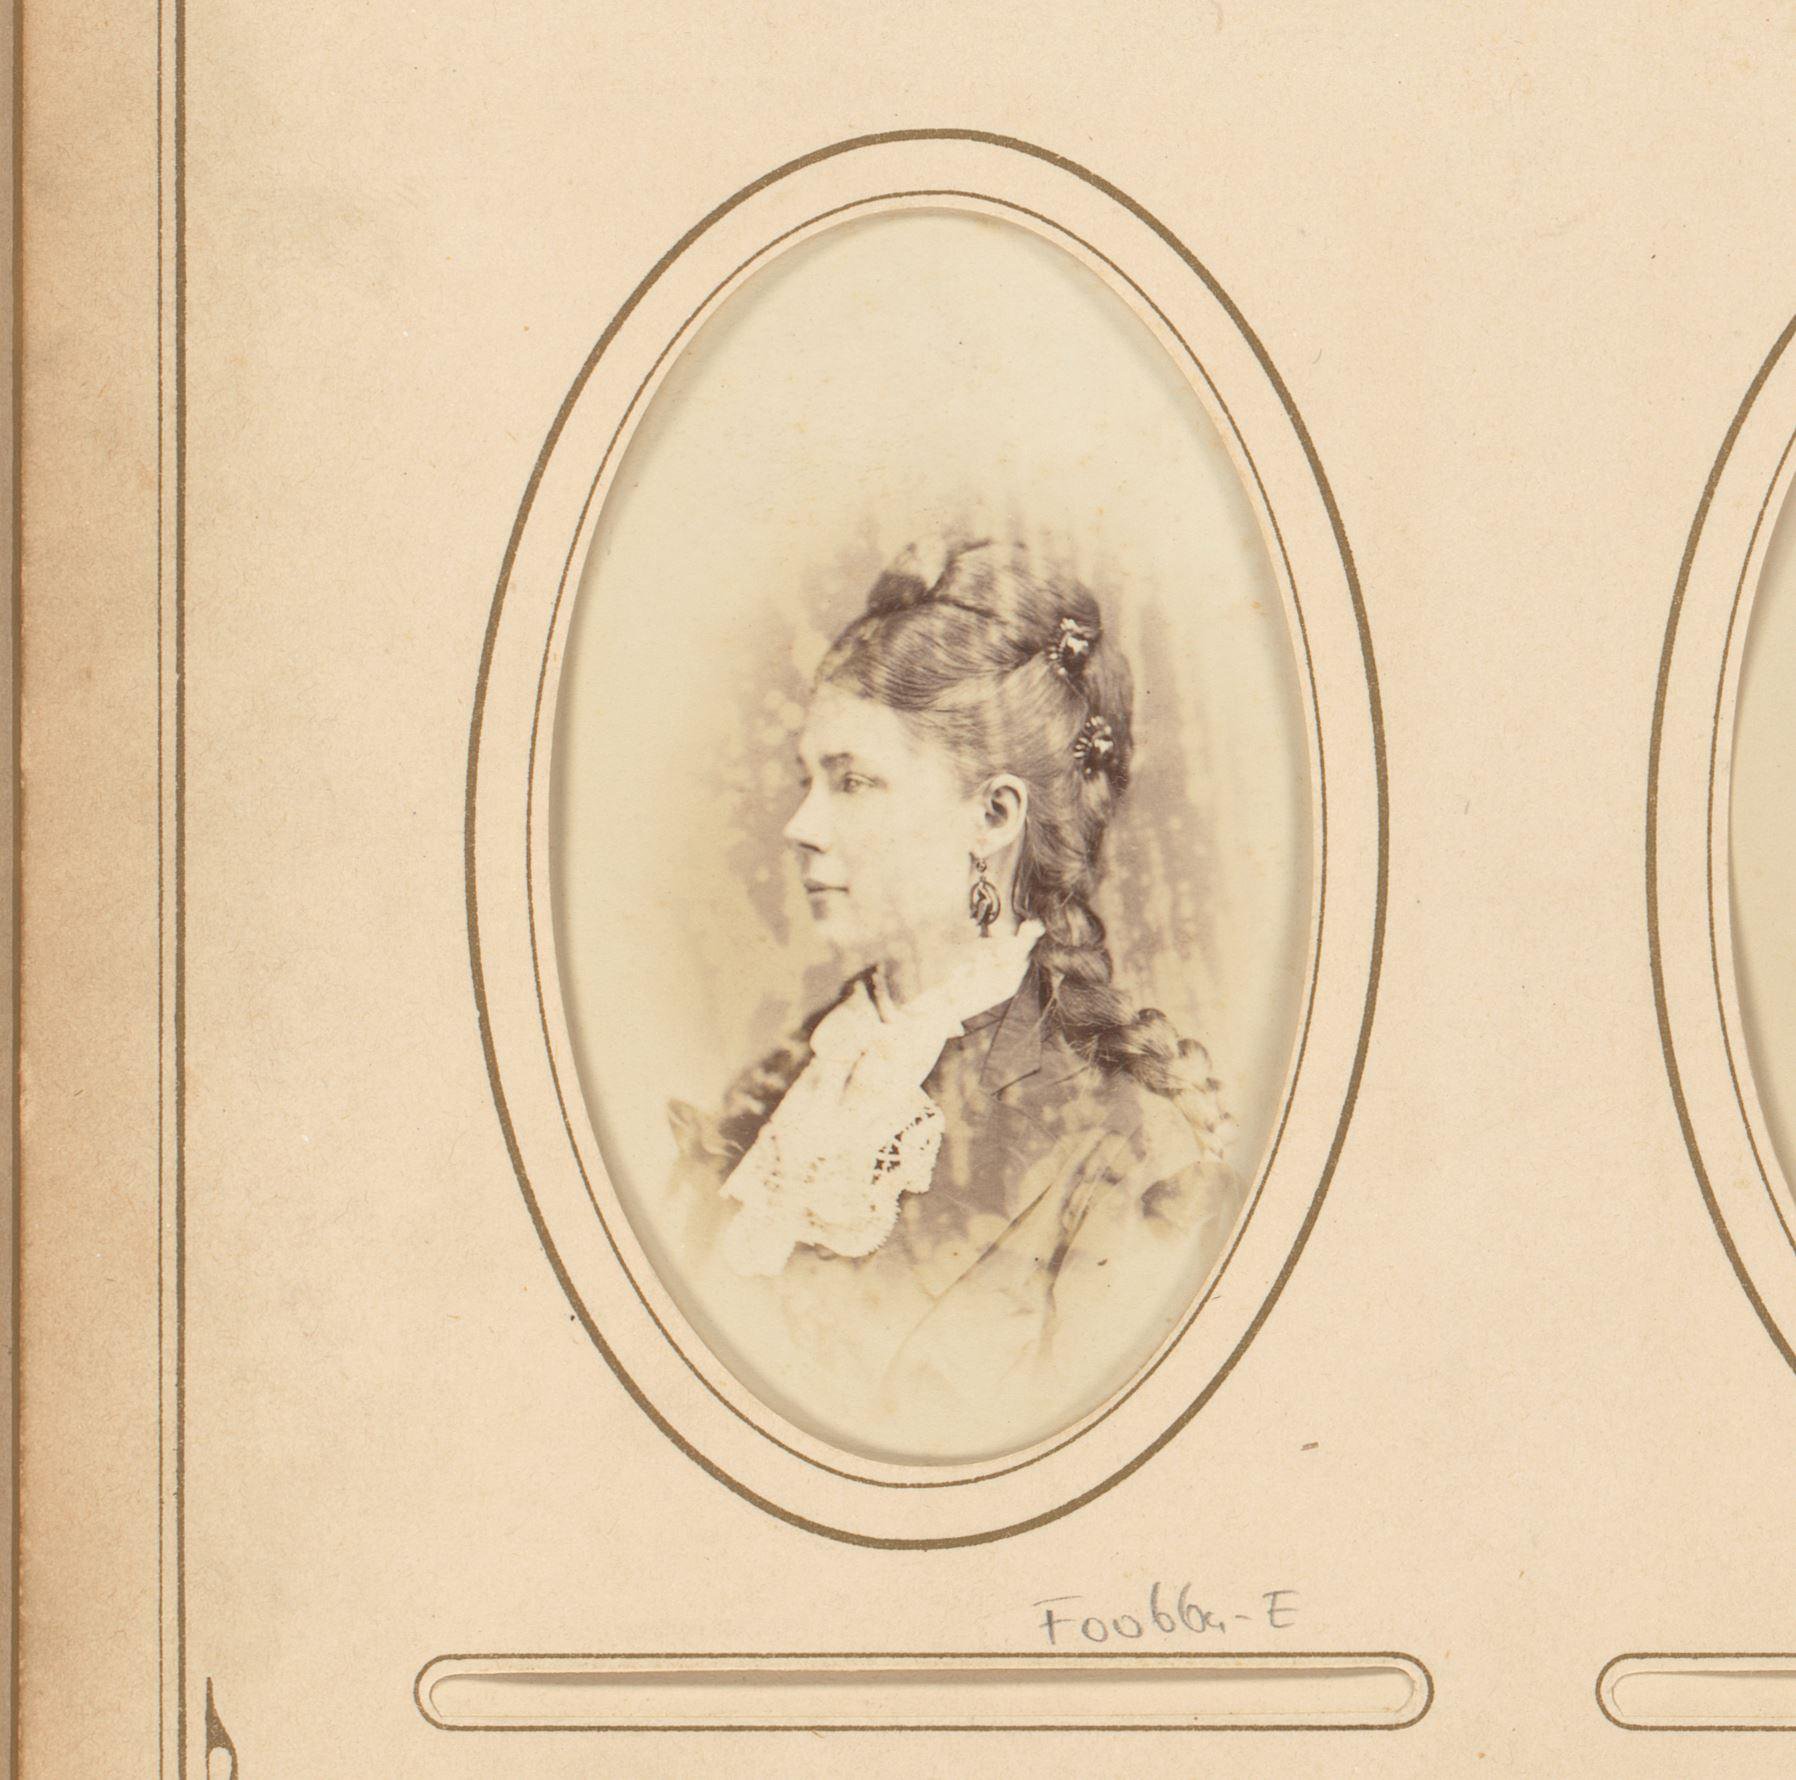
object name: photograph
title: Portret van Lientje Coster, aanstaande van J. van Delden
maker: petz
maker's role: fotograaf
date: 1860-1880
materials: cardboard, photographic support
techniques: albumen print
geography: batavia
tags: historical persons - bb - woman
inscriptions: inscription: ‘Atelier/ Petz & Co./ Java/ Batavia’, annotation: ‘Lientje Coster/ aanstaande van J van Delden/ merv. v. Braam’